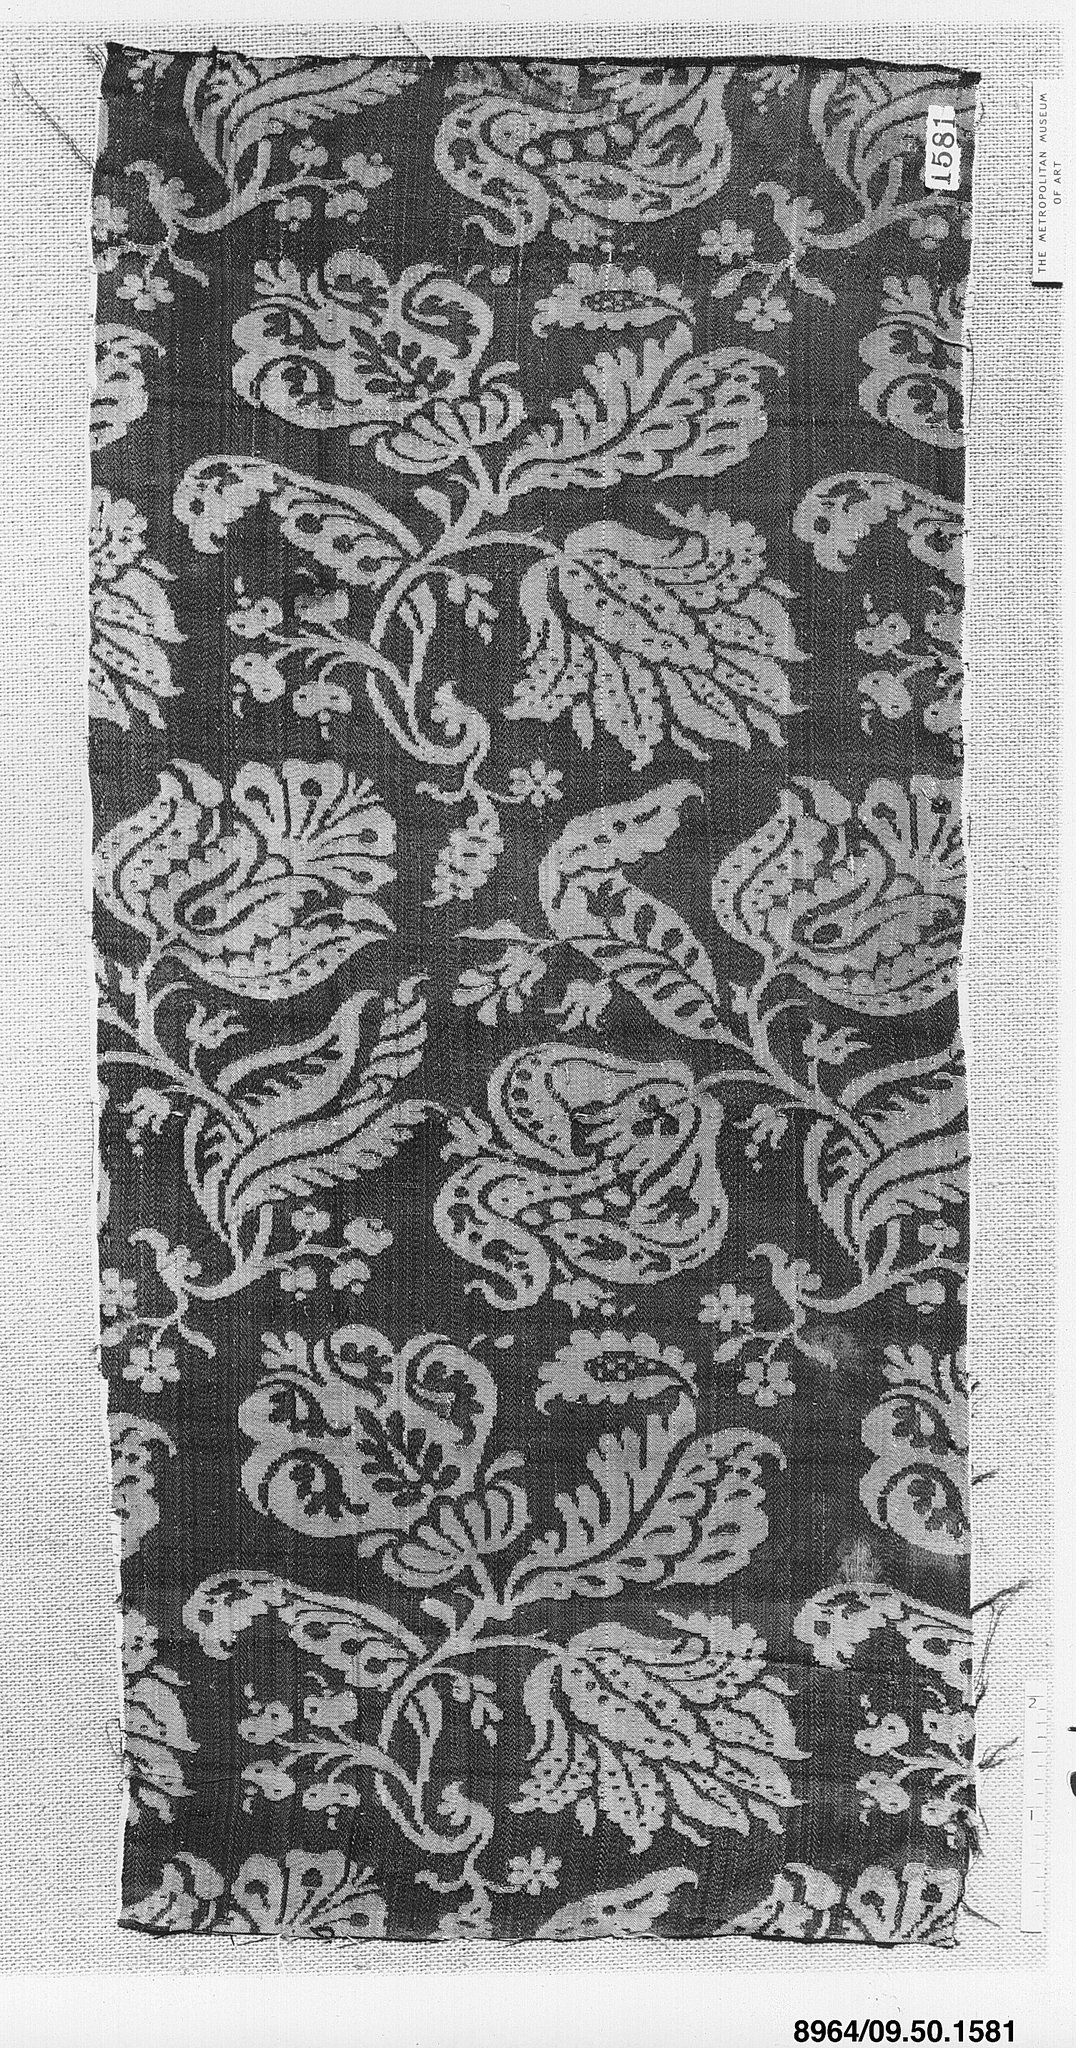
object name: piece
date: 1601-1700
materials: silk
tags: leaves